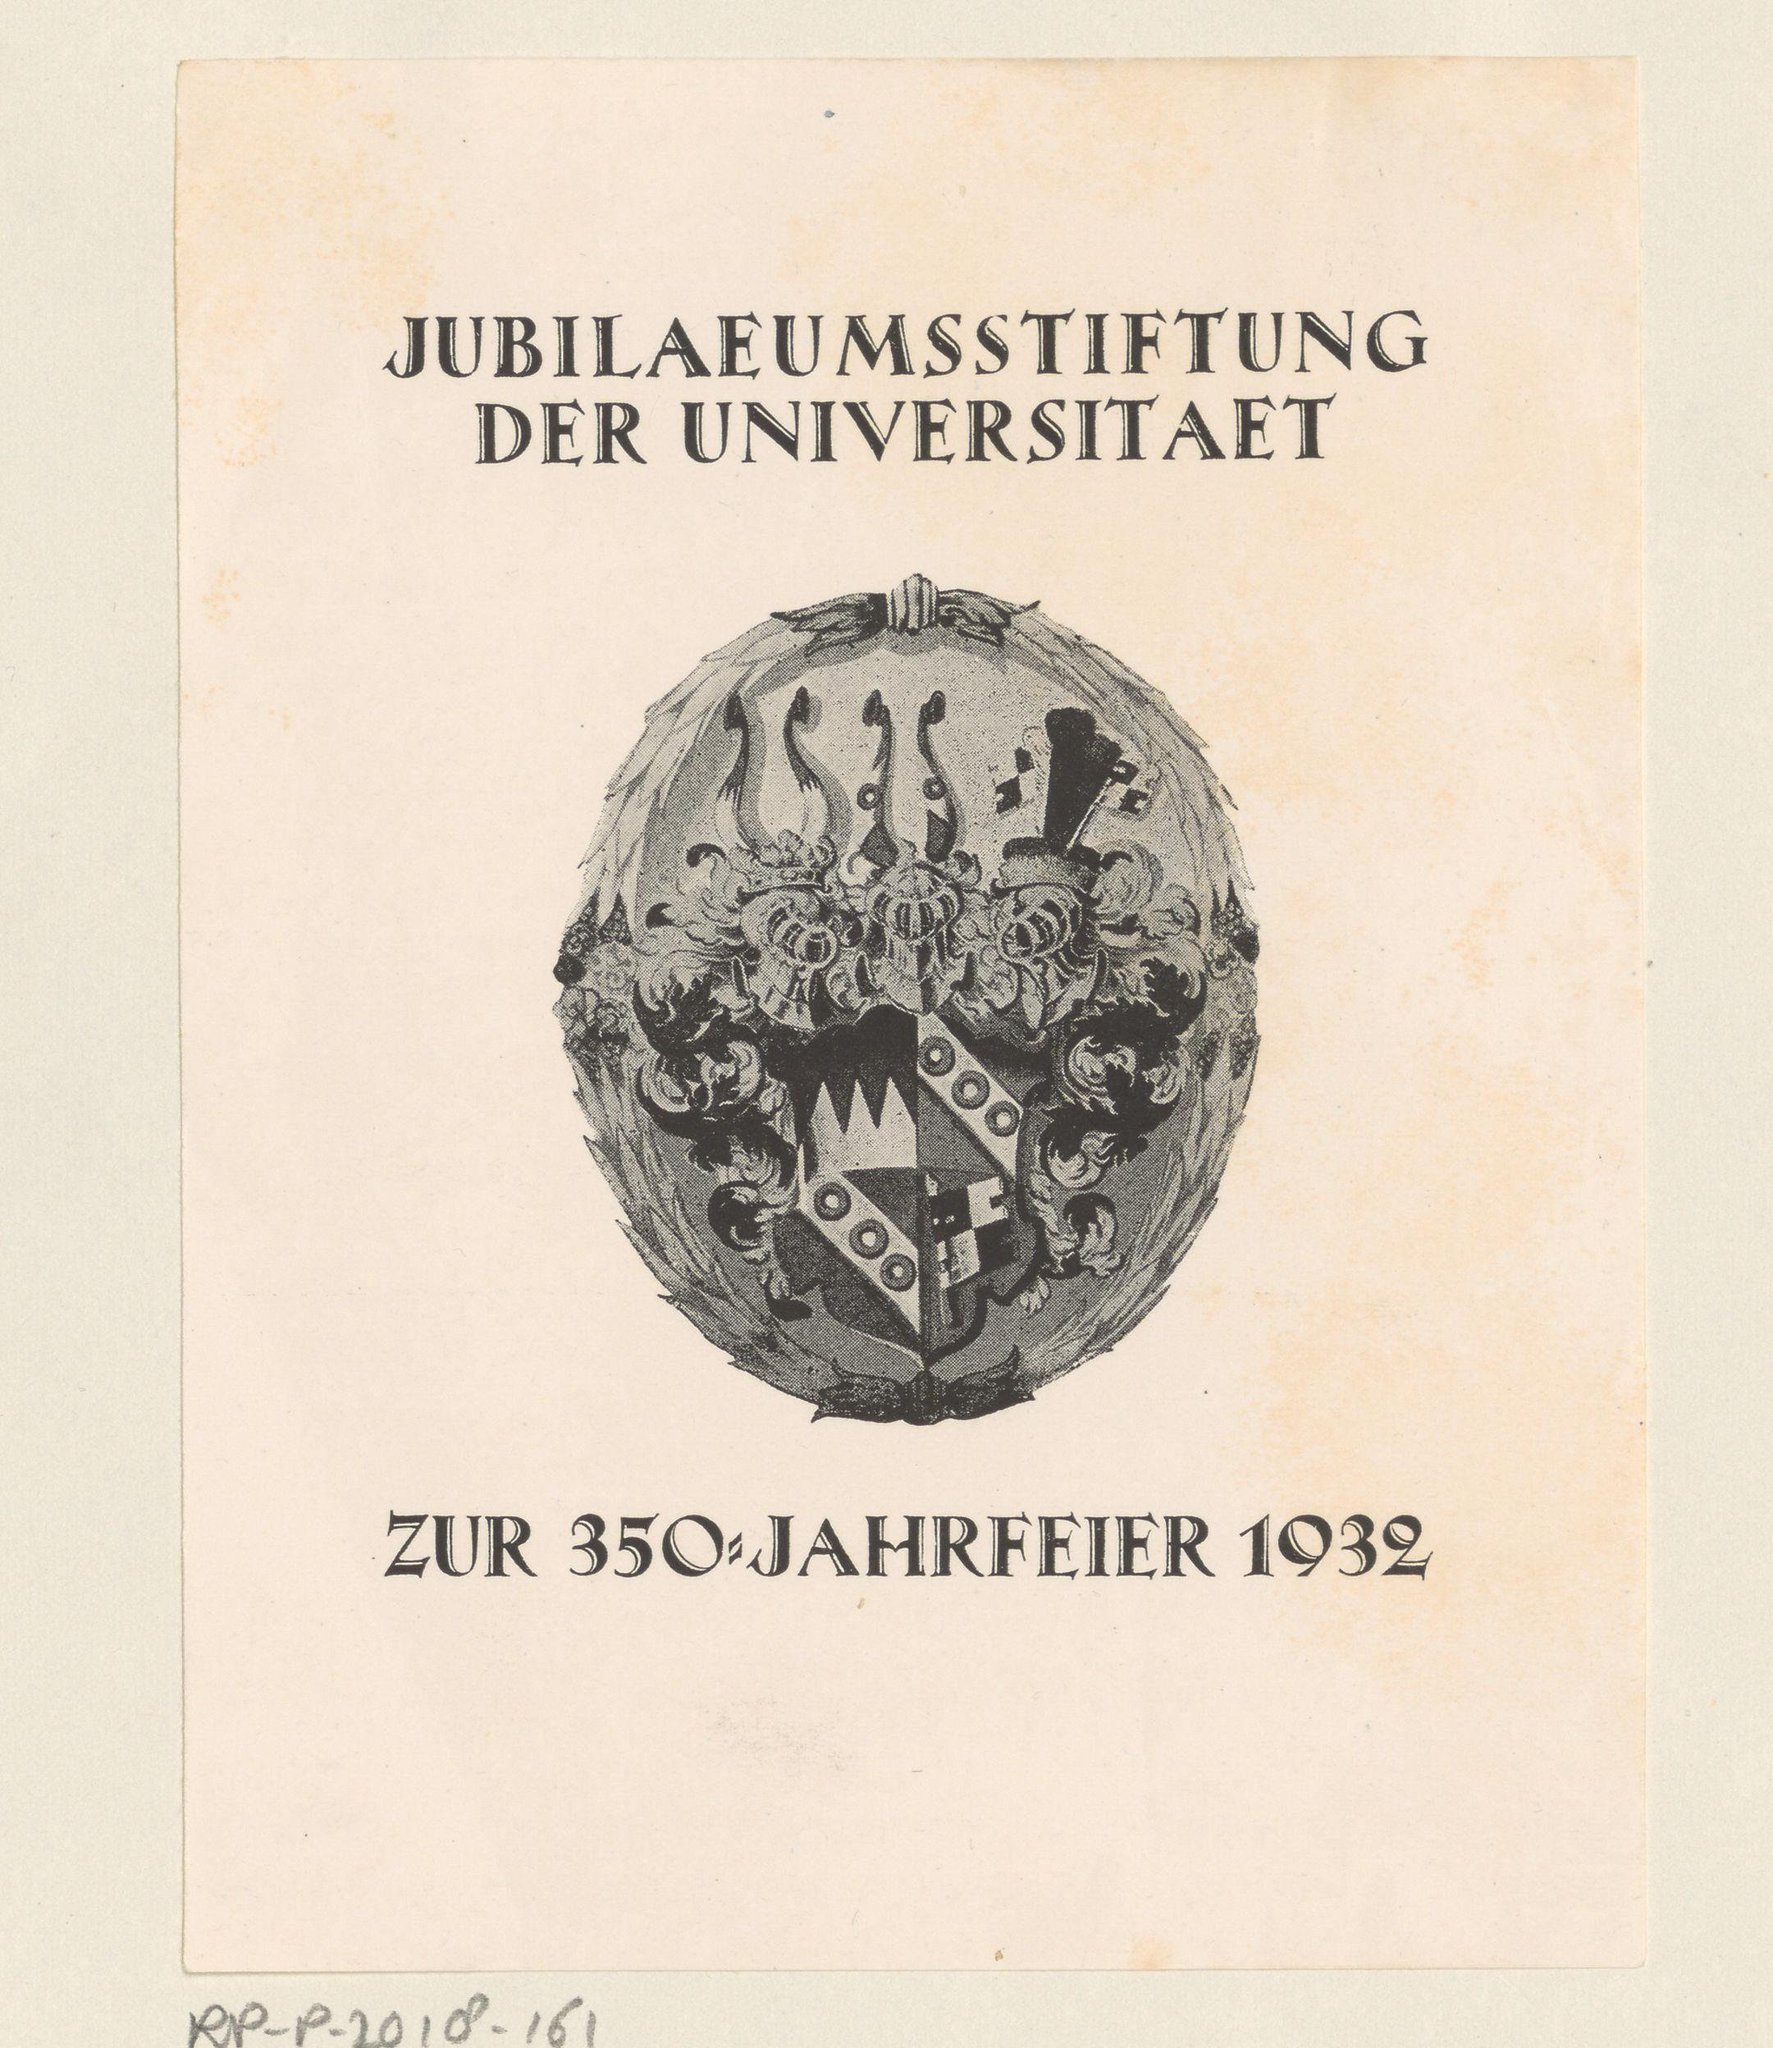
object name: bookplate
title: Jubilaeumsstiftung der Universitaet zur 350. Jahrfeier 1932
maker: Anonymous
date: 1932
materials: paper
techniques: autotype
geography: germany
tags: university, armorial bearing, heraldry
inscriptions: stamp: ‘Univ. Bibliothek/ Würzburg’